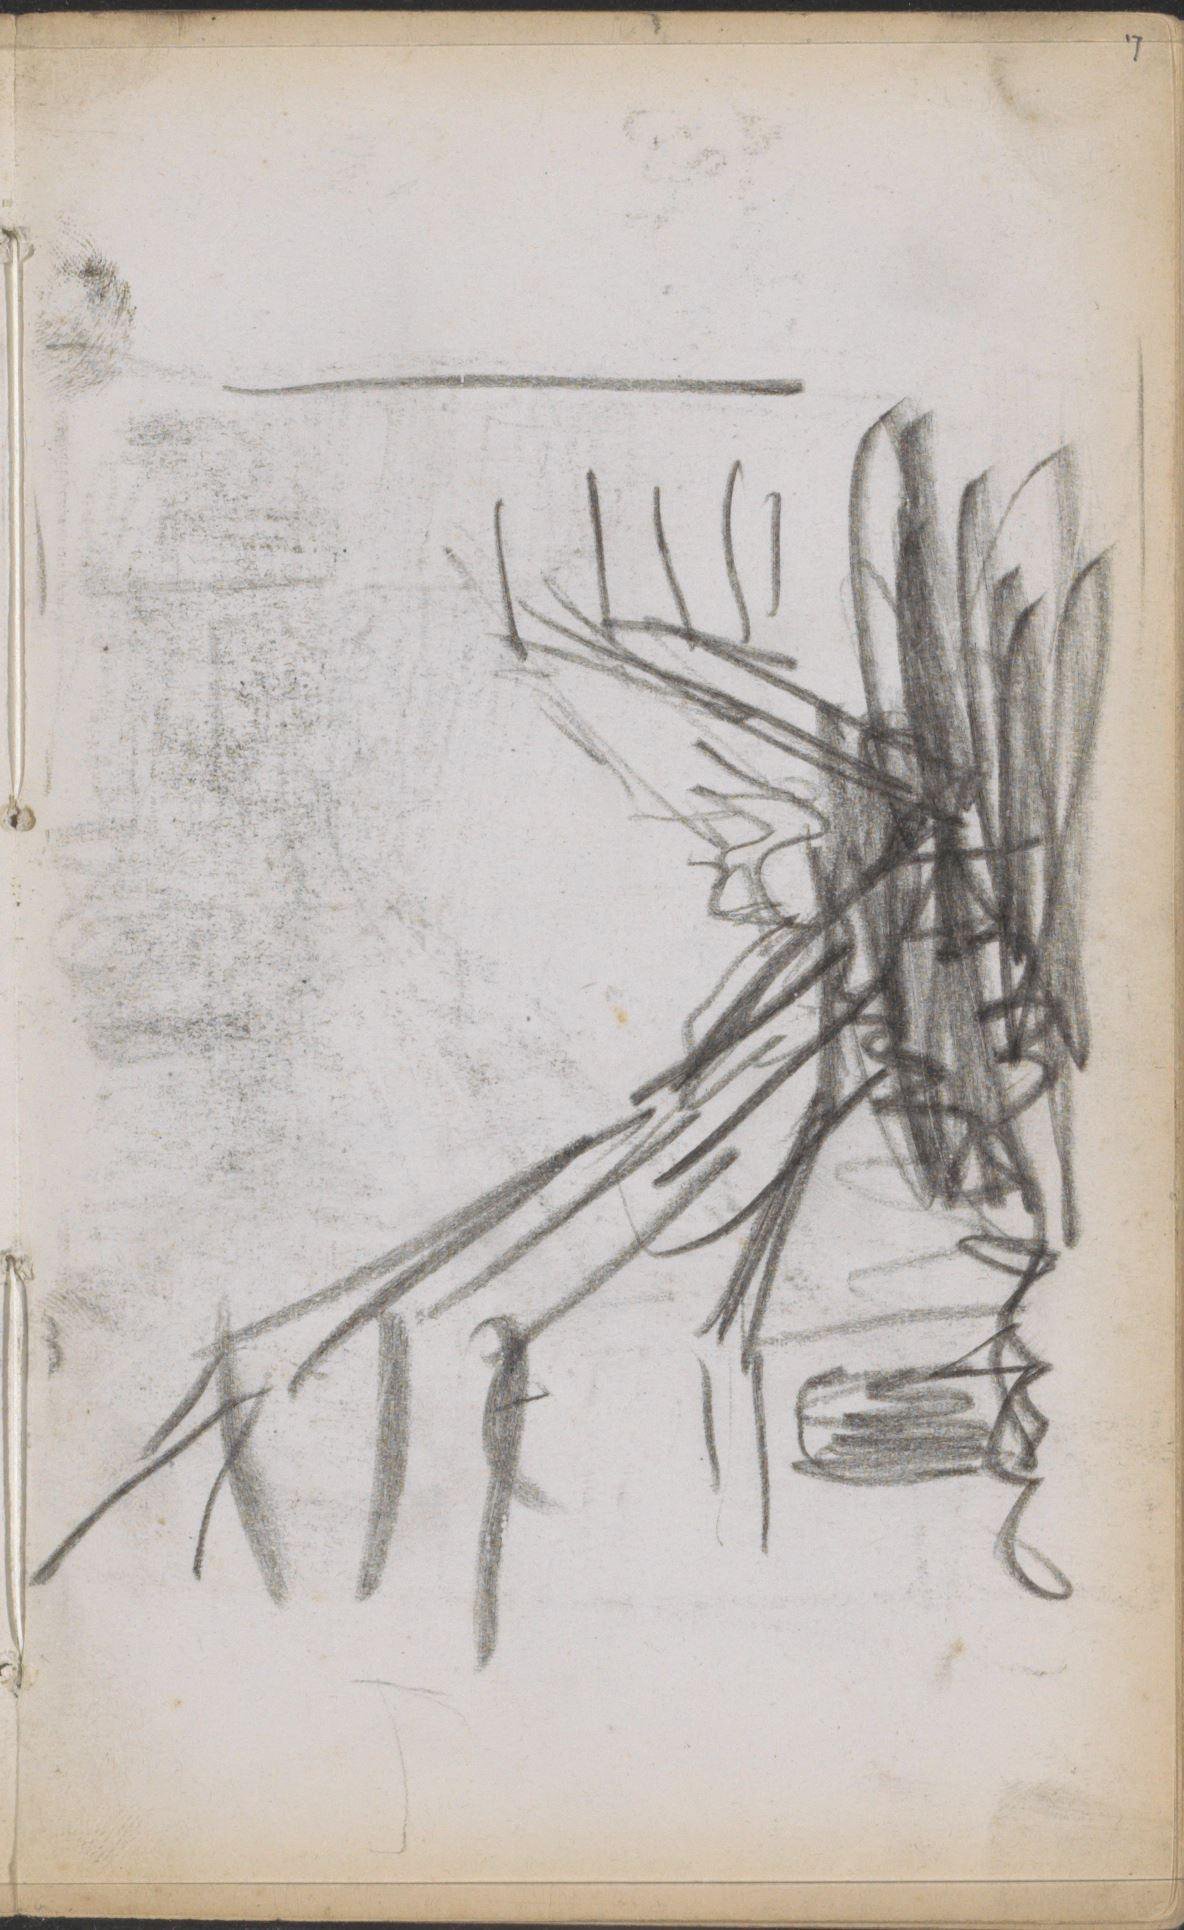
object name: sketchbook leaf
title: Straat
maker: marius bauer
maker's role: draughtsman, print maker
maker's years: 1867-1932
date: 1810-1891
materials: chalk, paper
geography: paris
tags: street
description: Vermoedelijk ook de Rue de Rivoli in Parijs, gezien de gelijkenis met de schets op pagina 16. Pagina 17 uit een schetsboek met 35 bladen.